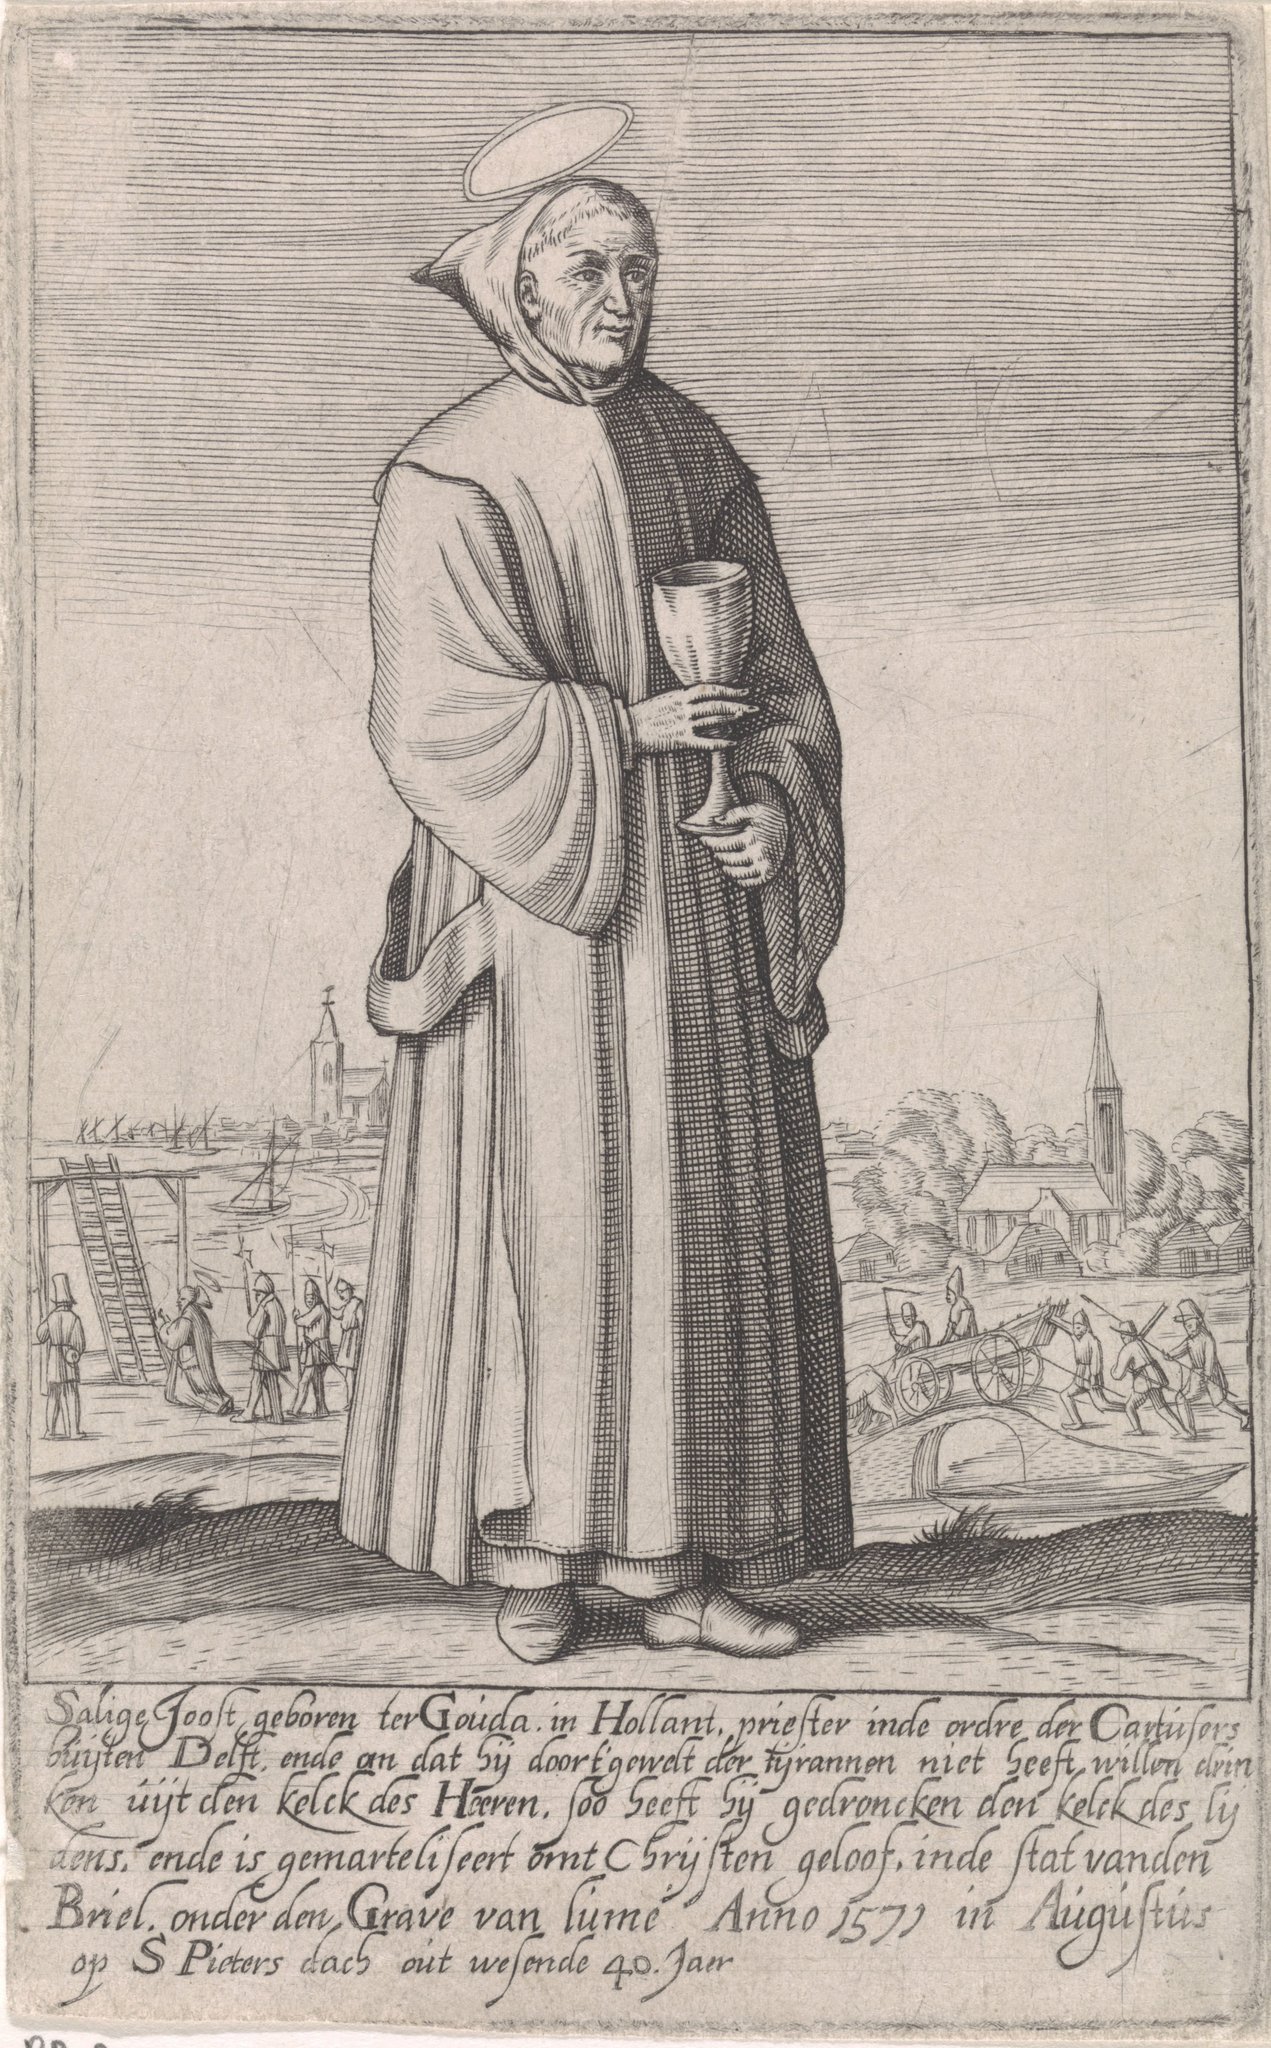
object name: print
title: Jodocus van Schoonhoven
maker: jacob matham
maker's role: draughtsman, print maker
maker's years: 1571-1631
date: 1607-1611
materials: paper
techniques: engraving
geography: haarlem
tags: male saints (with name), brielle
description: De zalige Jodocus (Joost) van Schoonhoven, martelaar te Den Briel. In zijn handen een misklek, waaruit hij weigerde te drinken.